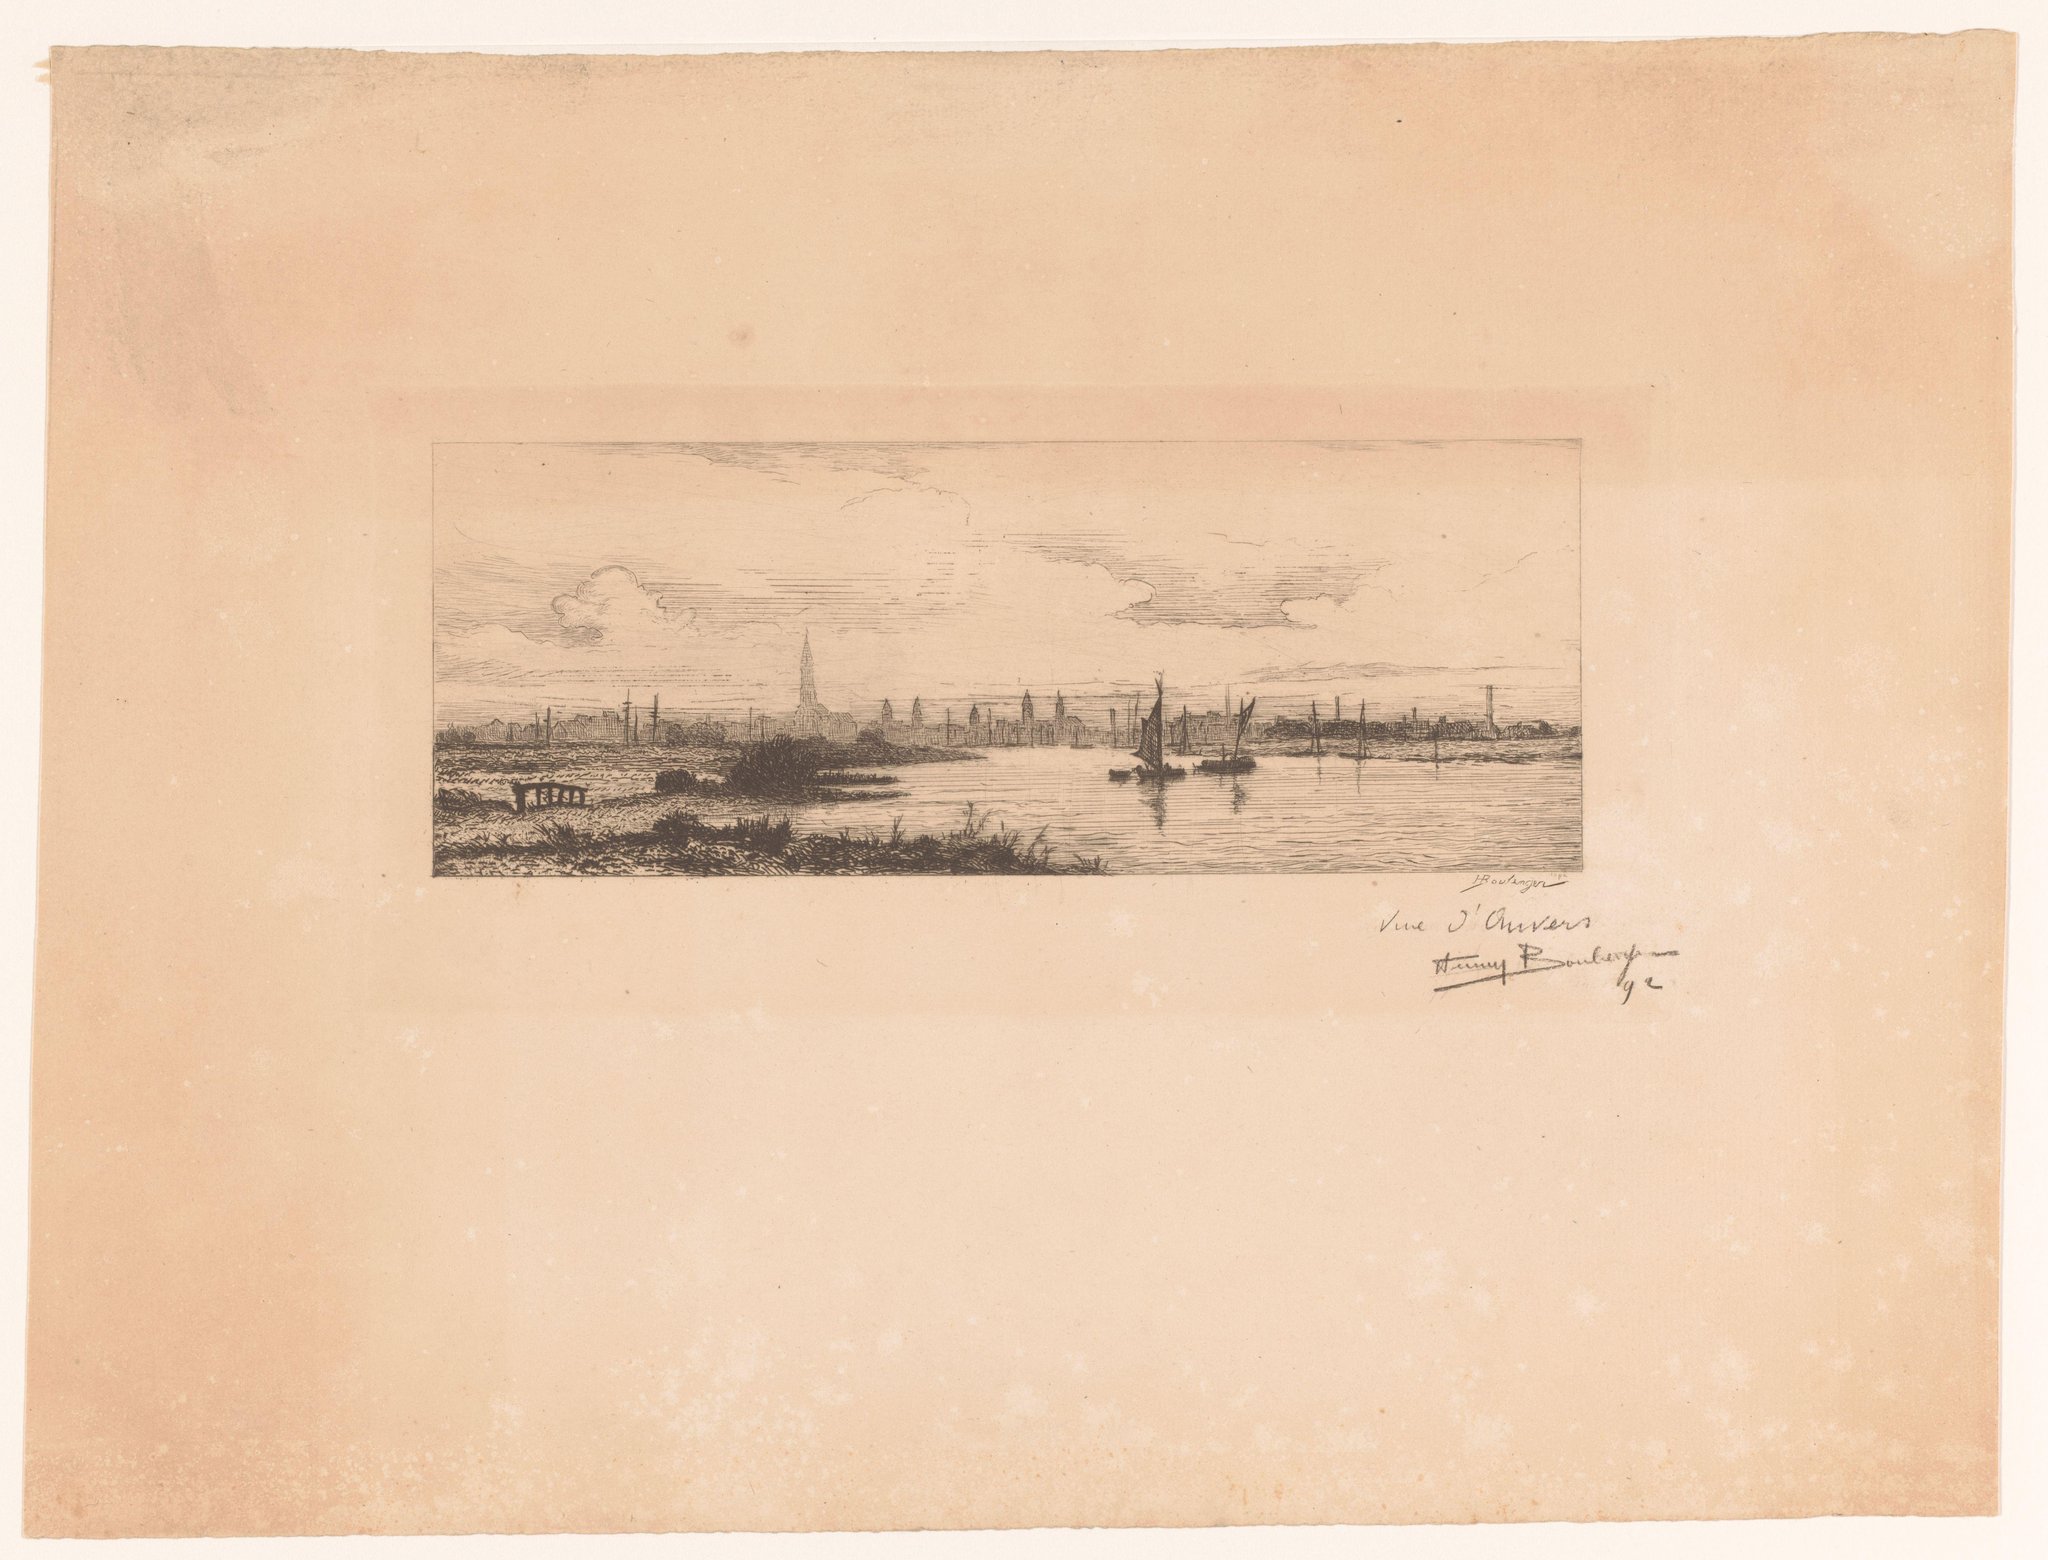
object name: print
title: Gezicht op de haven van Antwerpen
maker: herman boulenger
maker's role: draughtsman, print maker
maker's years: 1871-1913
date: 1892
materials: paper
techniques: drypoint, etching, intaglio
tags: harbour, prospect of city, town panorama, silhouette of city, antwerp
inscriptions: collector's mark: Lugt 2228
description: Sterfdatum kunstenaar onbekend. Derhalve is voor bepaling van de rechten van dit object de verwervingsdatum aangehouden.